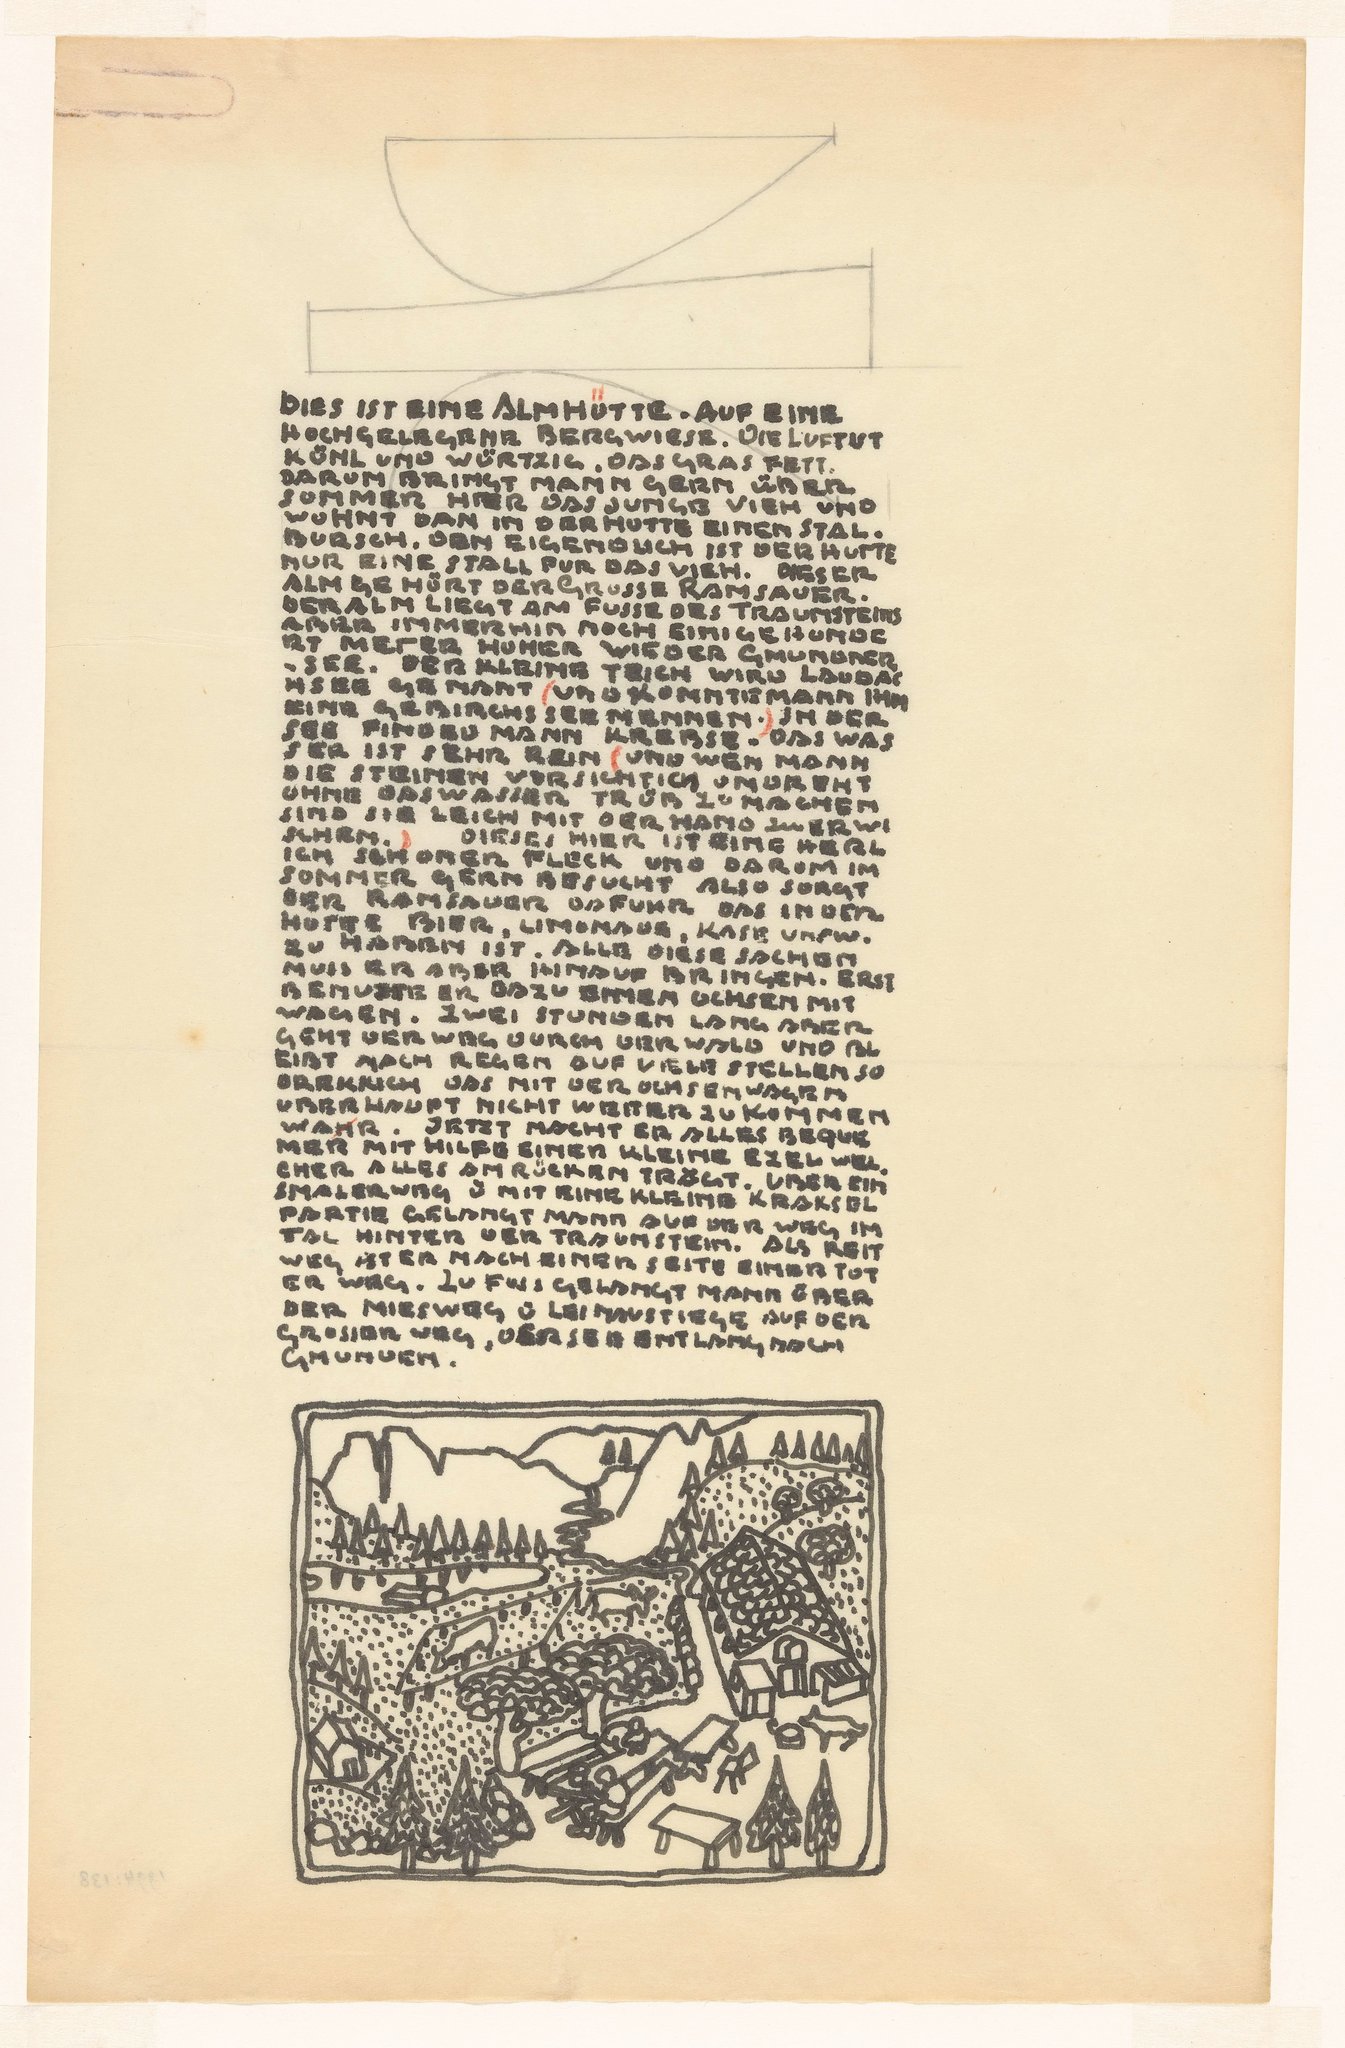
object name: text sheet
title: Gezicht op een berghut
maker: reijer stolk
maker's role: draughtsman, print maker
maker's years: 1896-1945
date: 1922-1926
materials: ink, paper, pencil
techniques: pen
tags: landscapes, hut, cabin, lodge, mountains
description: Tekstblad met daaronder een gezicht op een berghut waar figuren aan een tafel zitten.